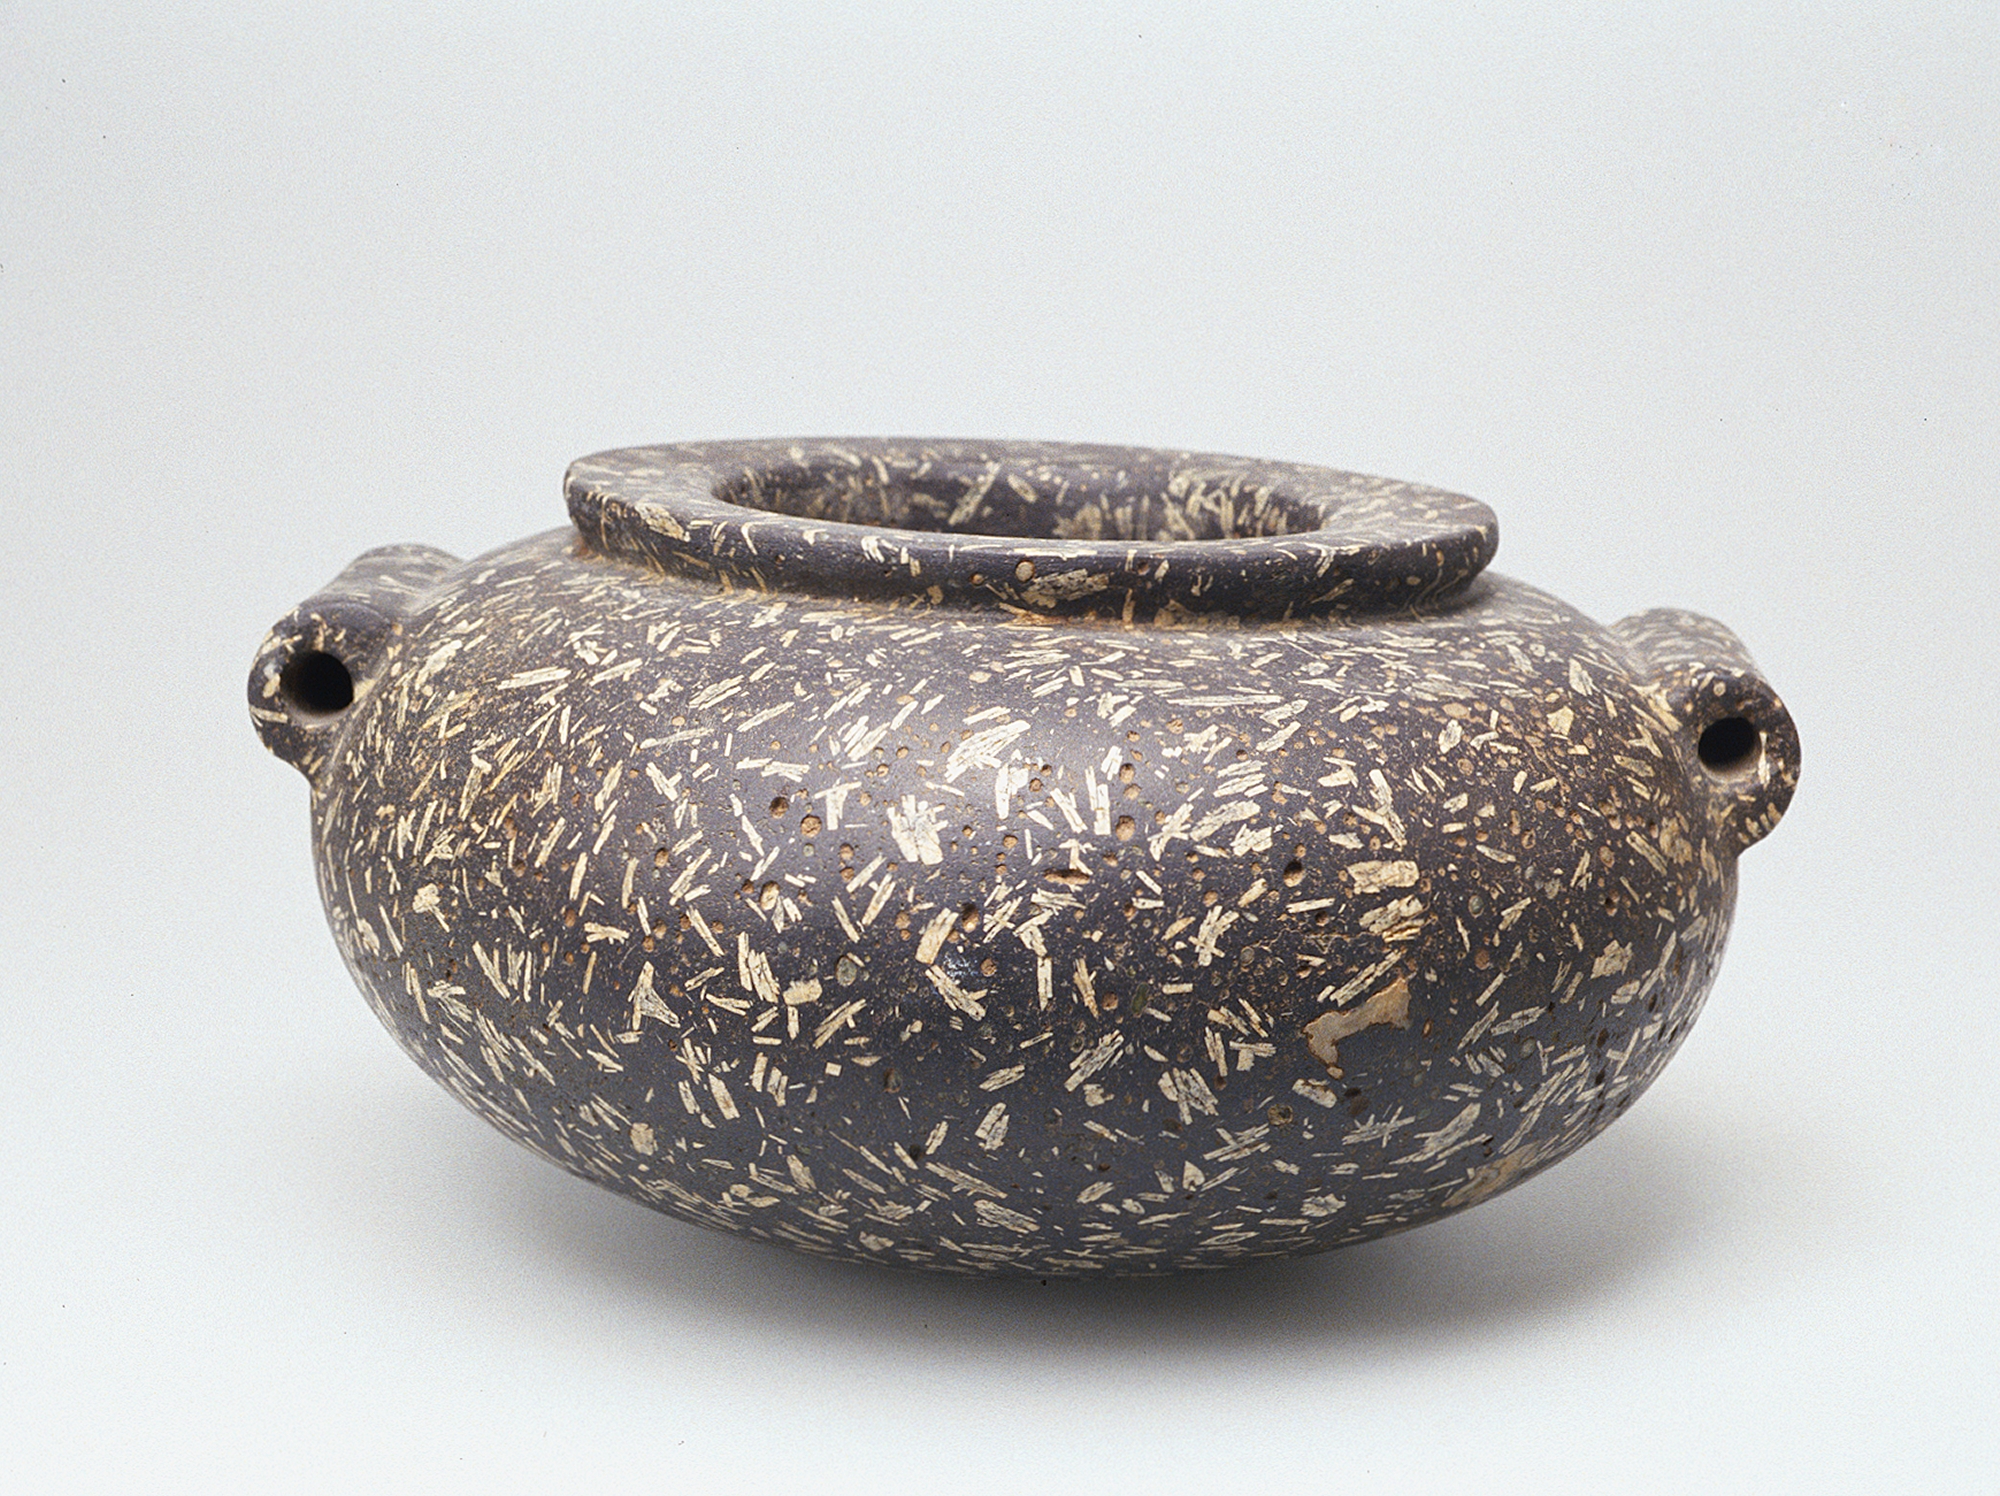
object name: jar, lug handle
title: Stone Jar with Lug Handles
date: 2960-2649 BCE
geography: egypt